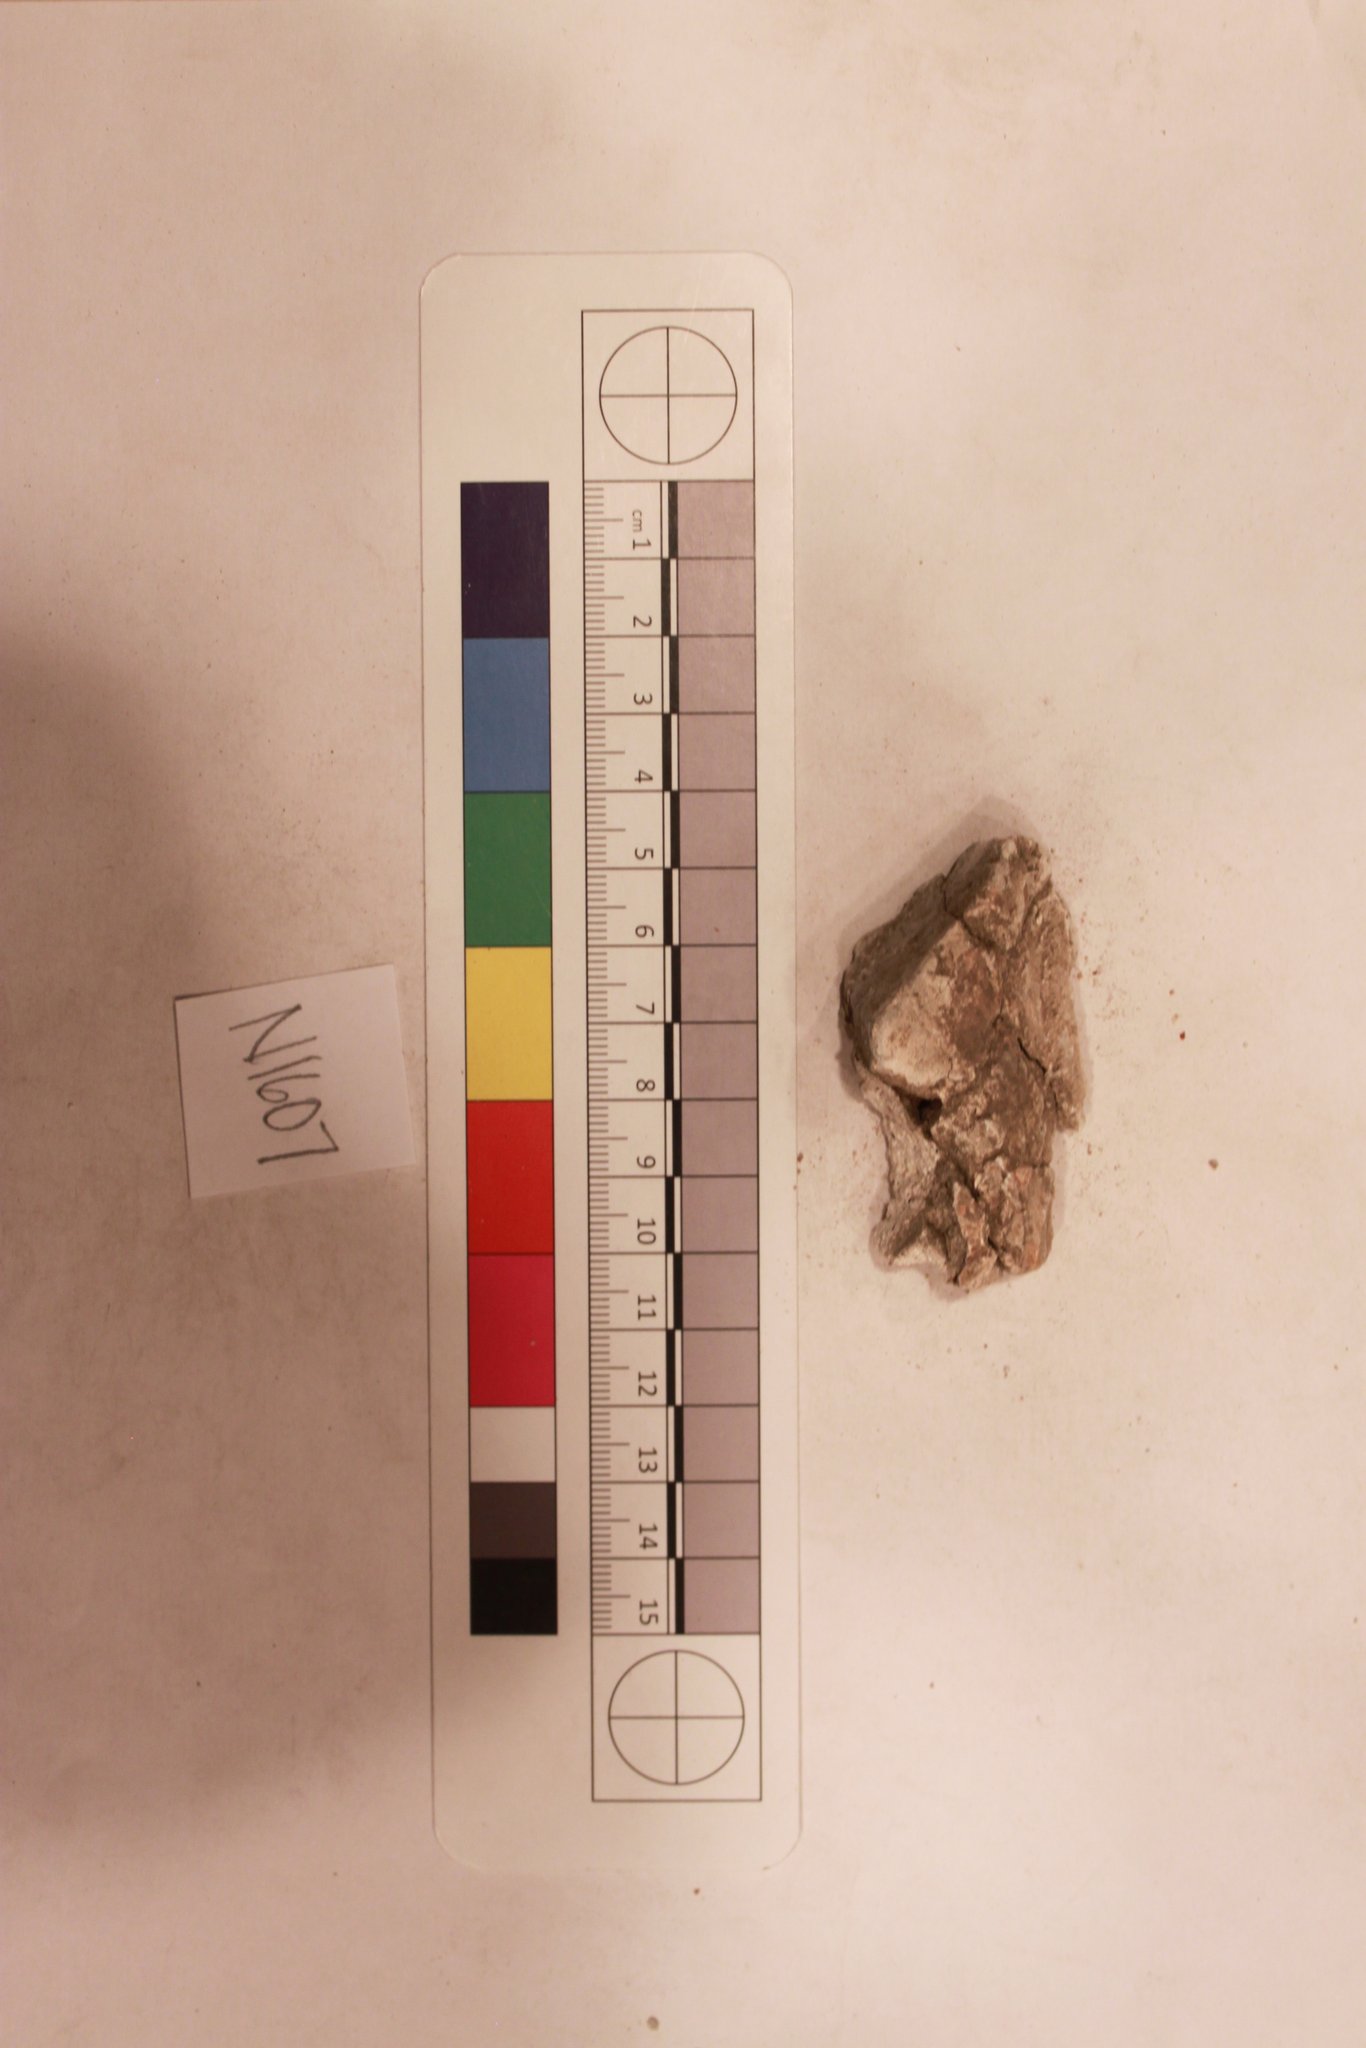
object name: fragment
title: Stucco Fragment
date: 701-1200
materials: plaster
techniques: carving, painting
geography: iran